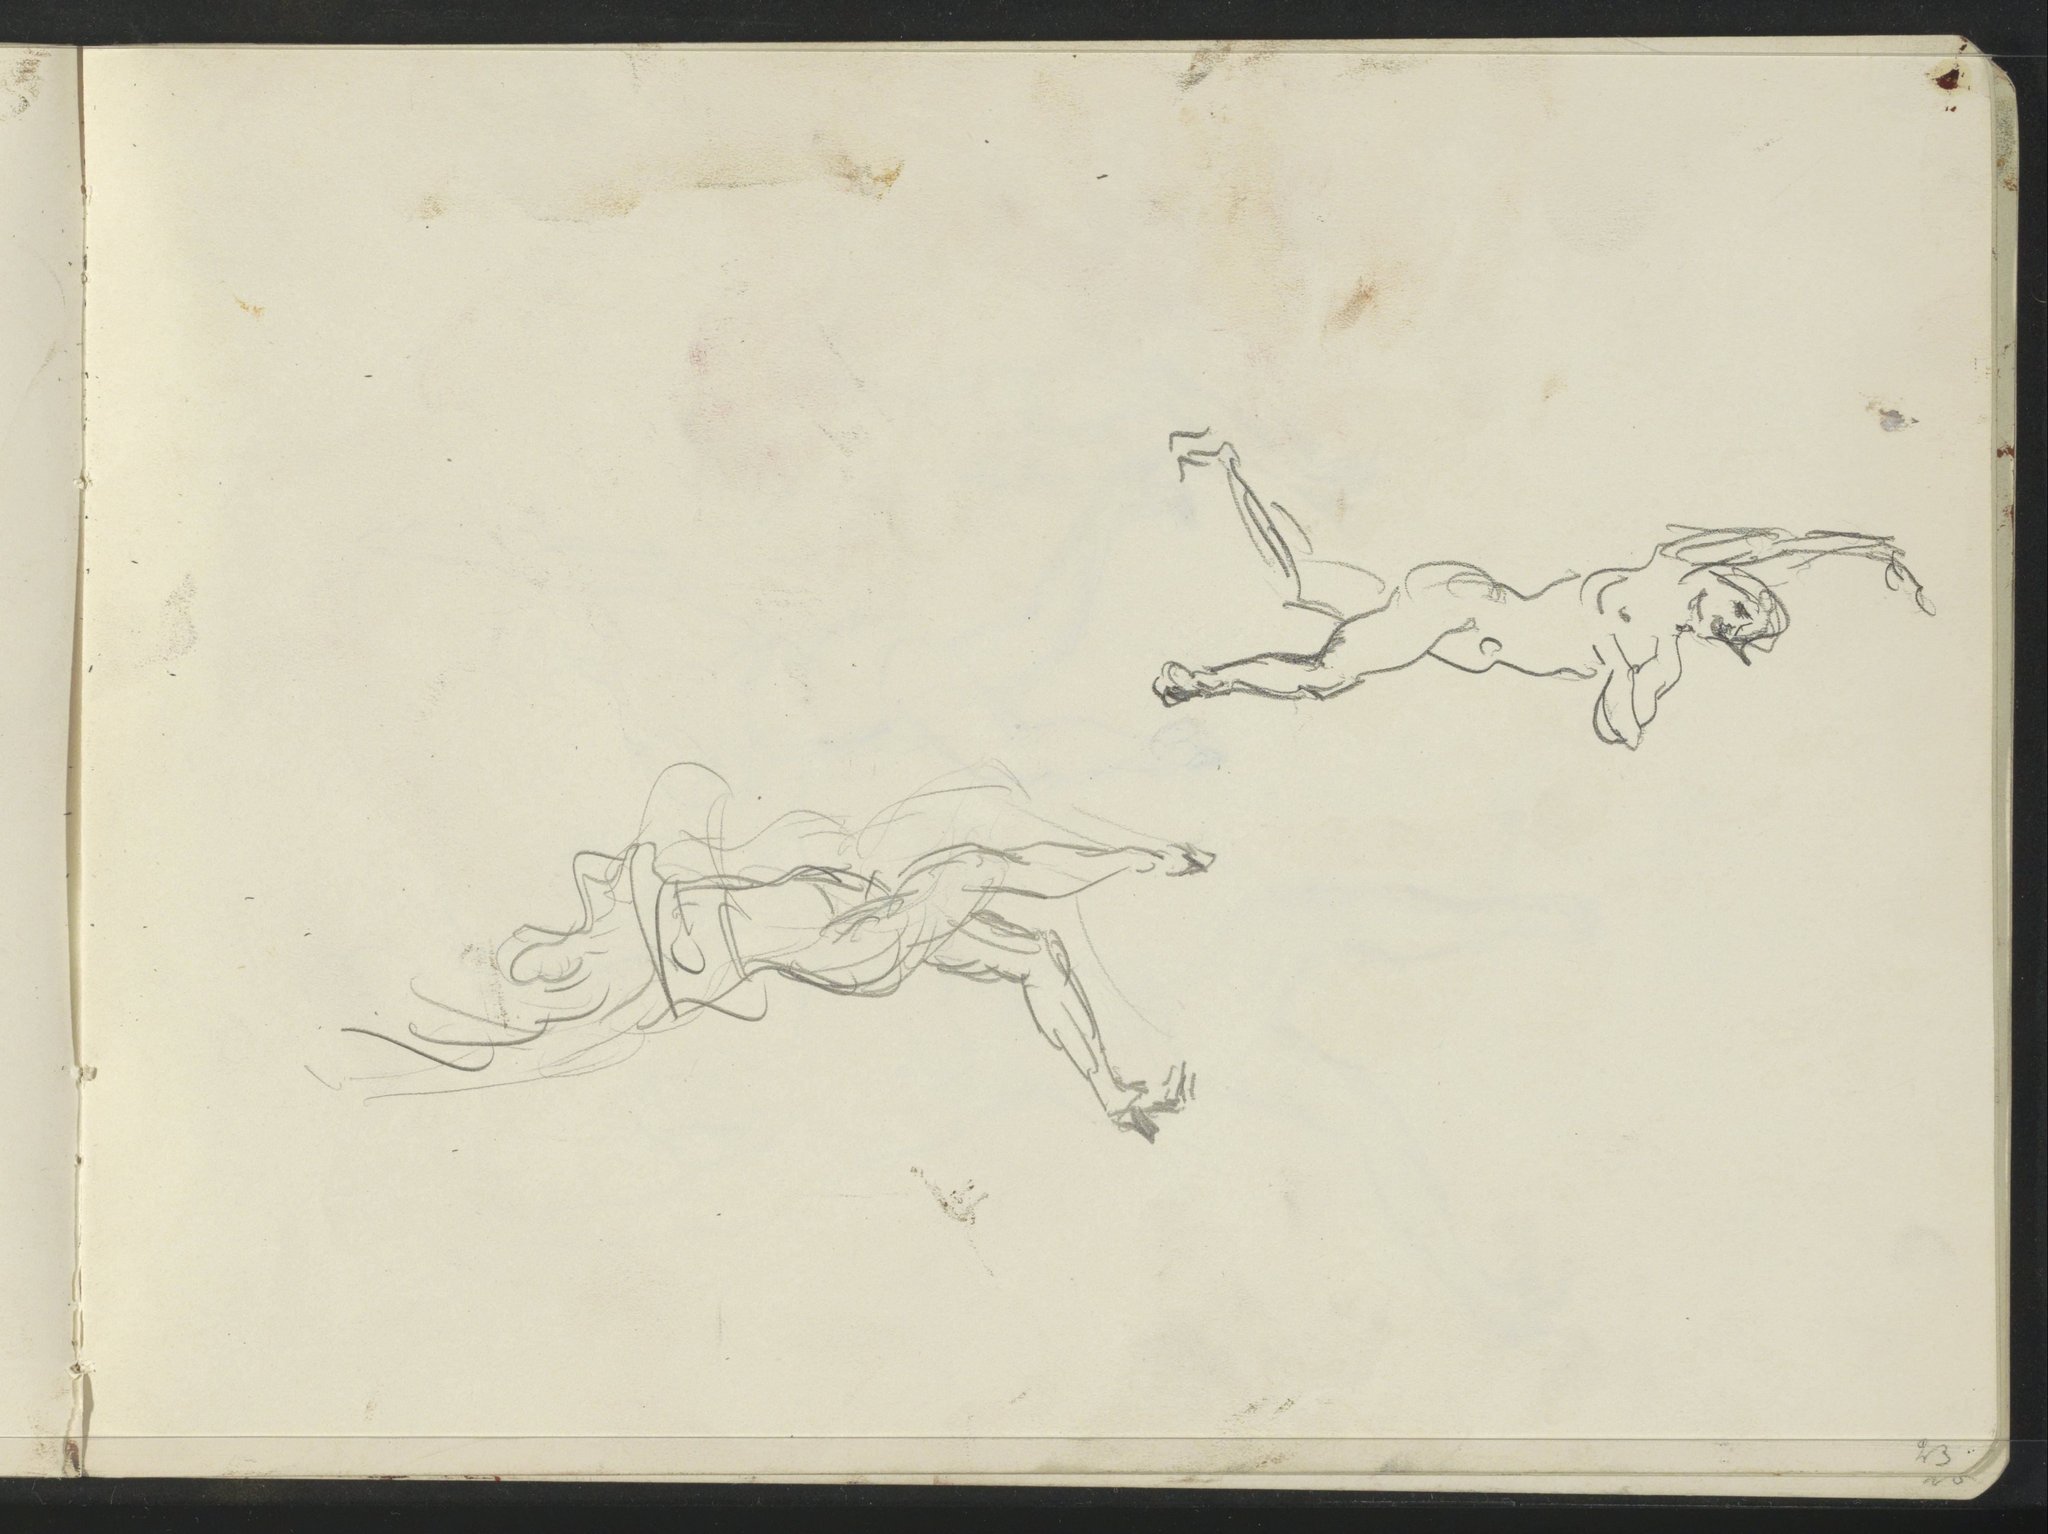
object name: sketchbook leaf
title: Twee studies van vrouwelijk naakt, mogelijk dansend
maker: isaac israels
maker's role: draughtsman, painter, print maker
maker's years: 1865-1934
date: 1915-1934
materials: paper, pencil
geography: the hague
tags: the (nude) human figure; 'corpo humano' (ripa) - aa - female human figure (+ standing), female dancer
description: Blad 23 recto uit schetsboek XVIII met 35 bladen.